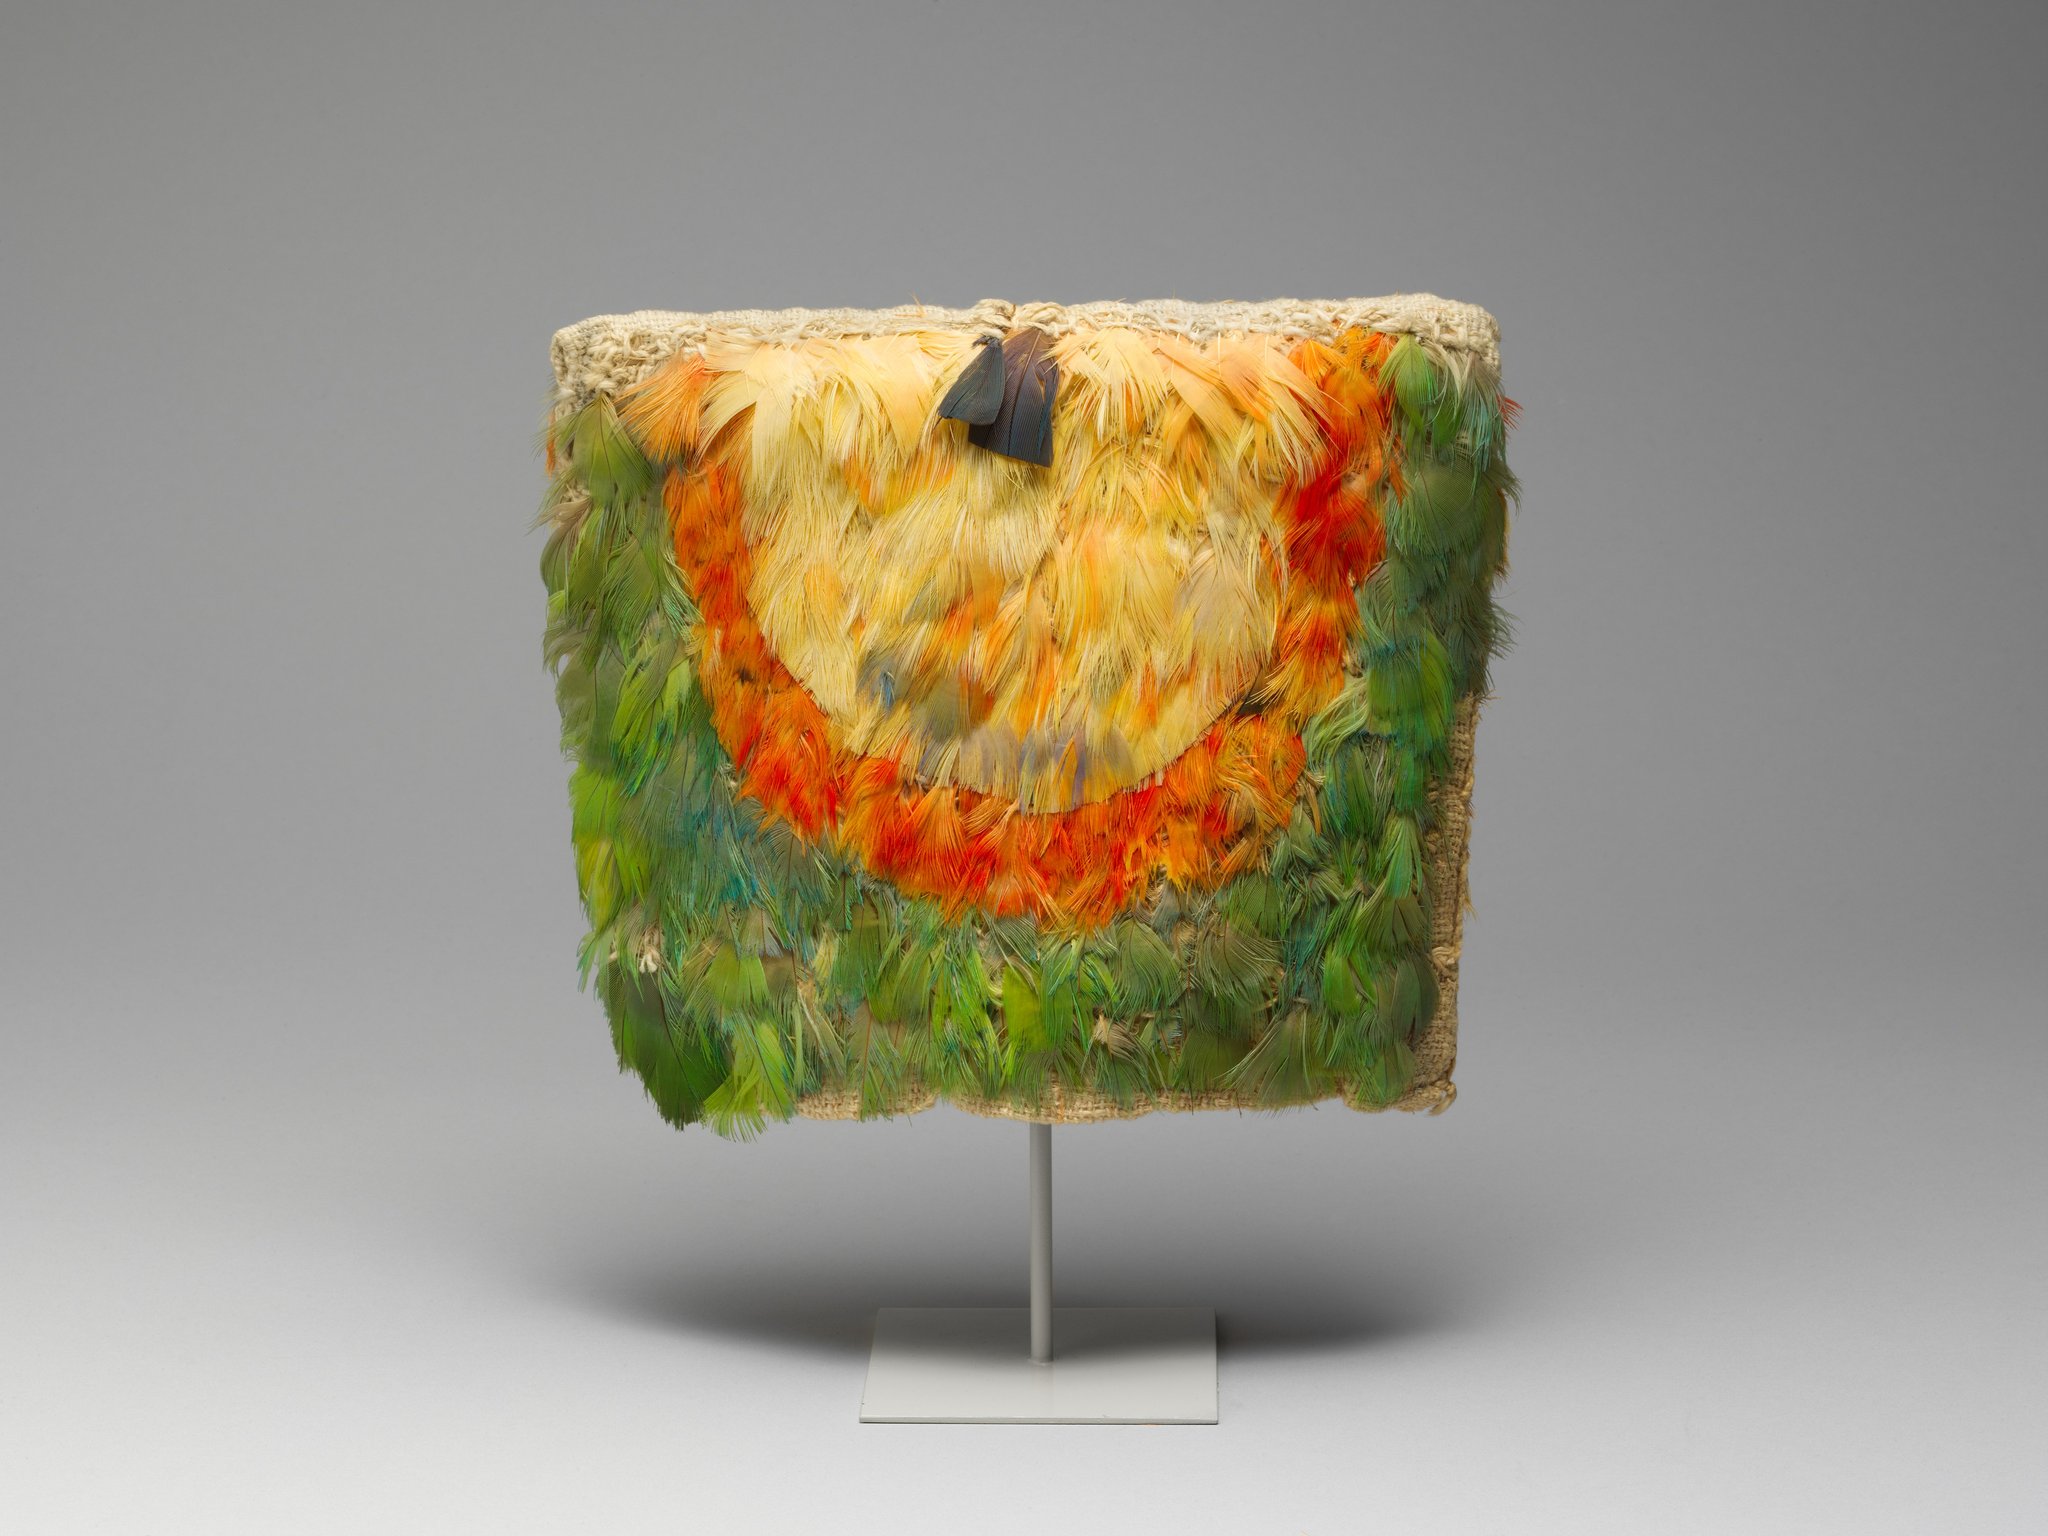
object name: miniature tunic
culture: ica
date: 1101-1300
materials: cotton, feather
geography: peru